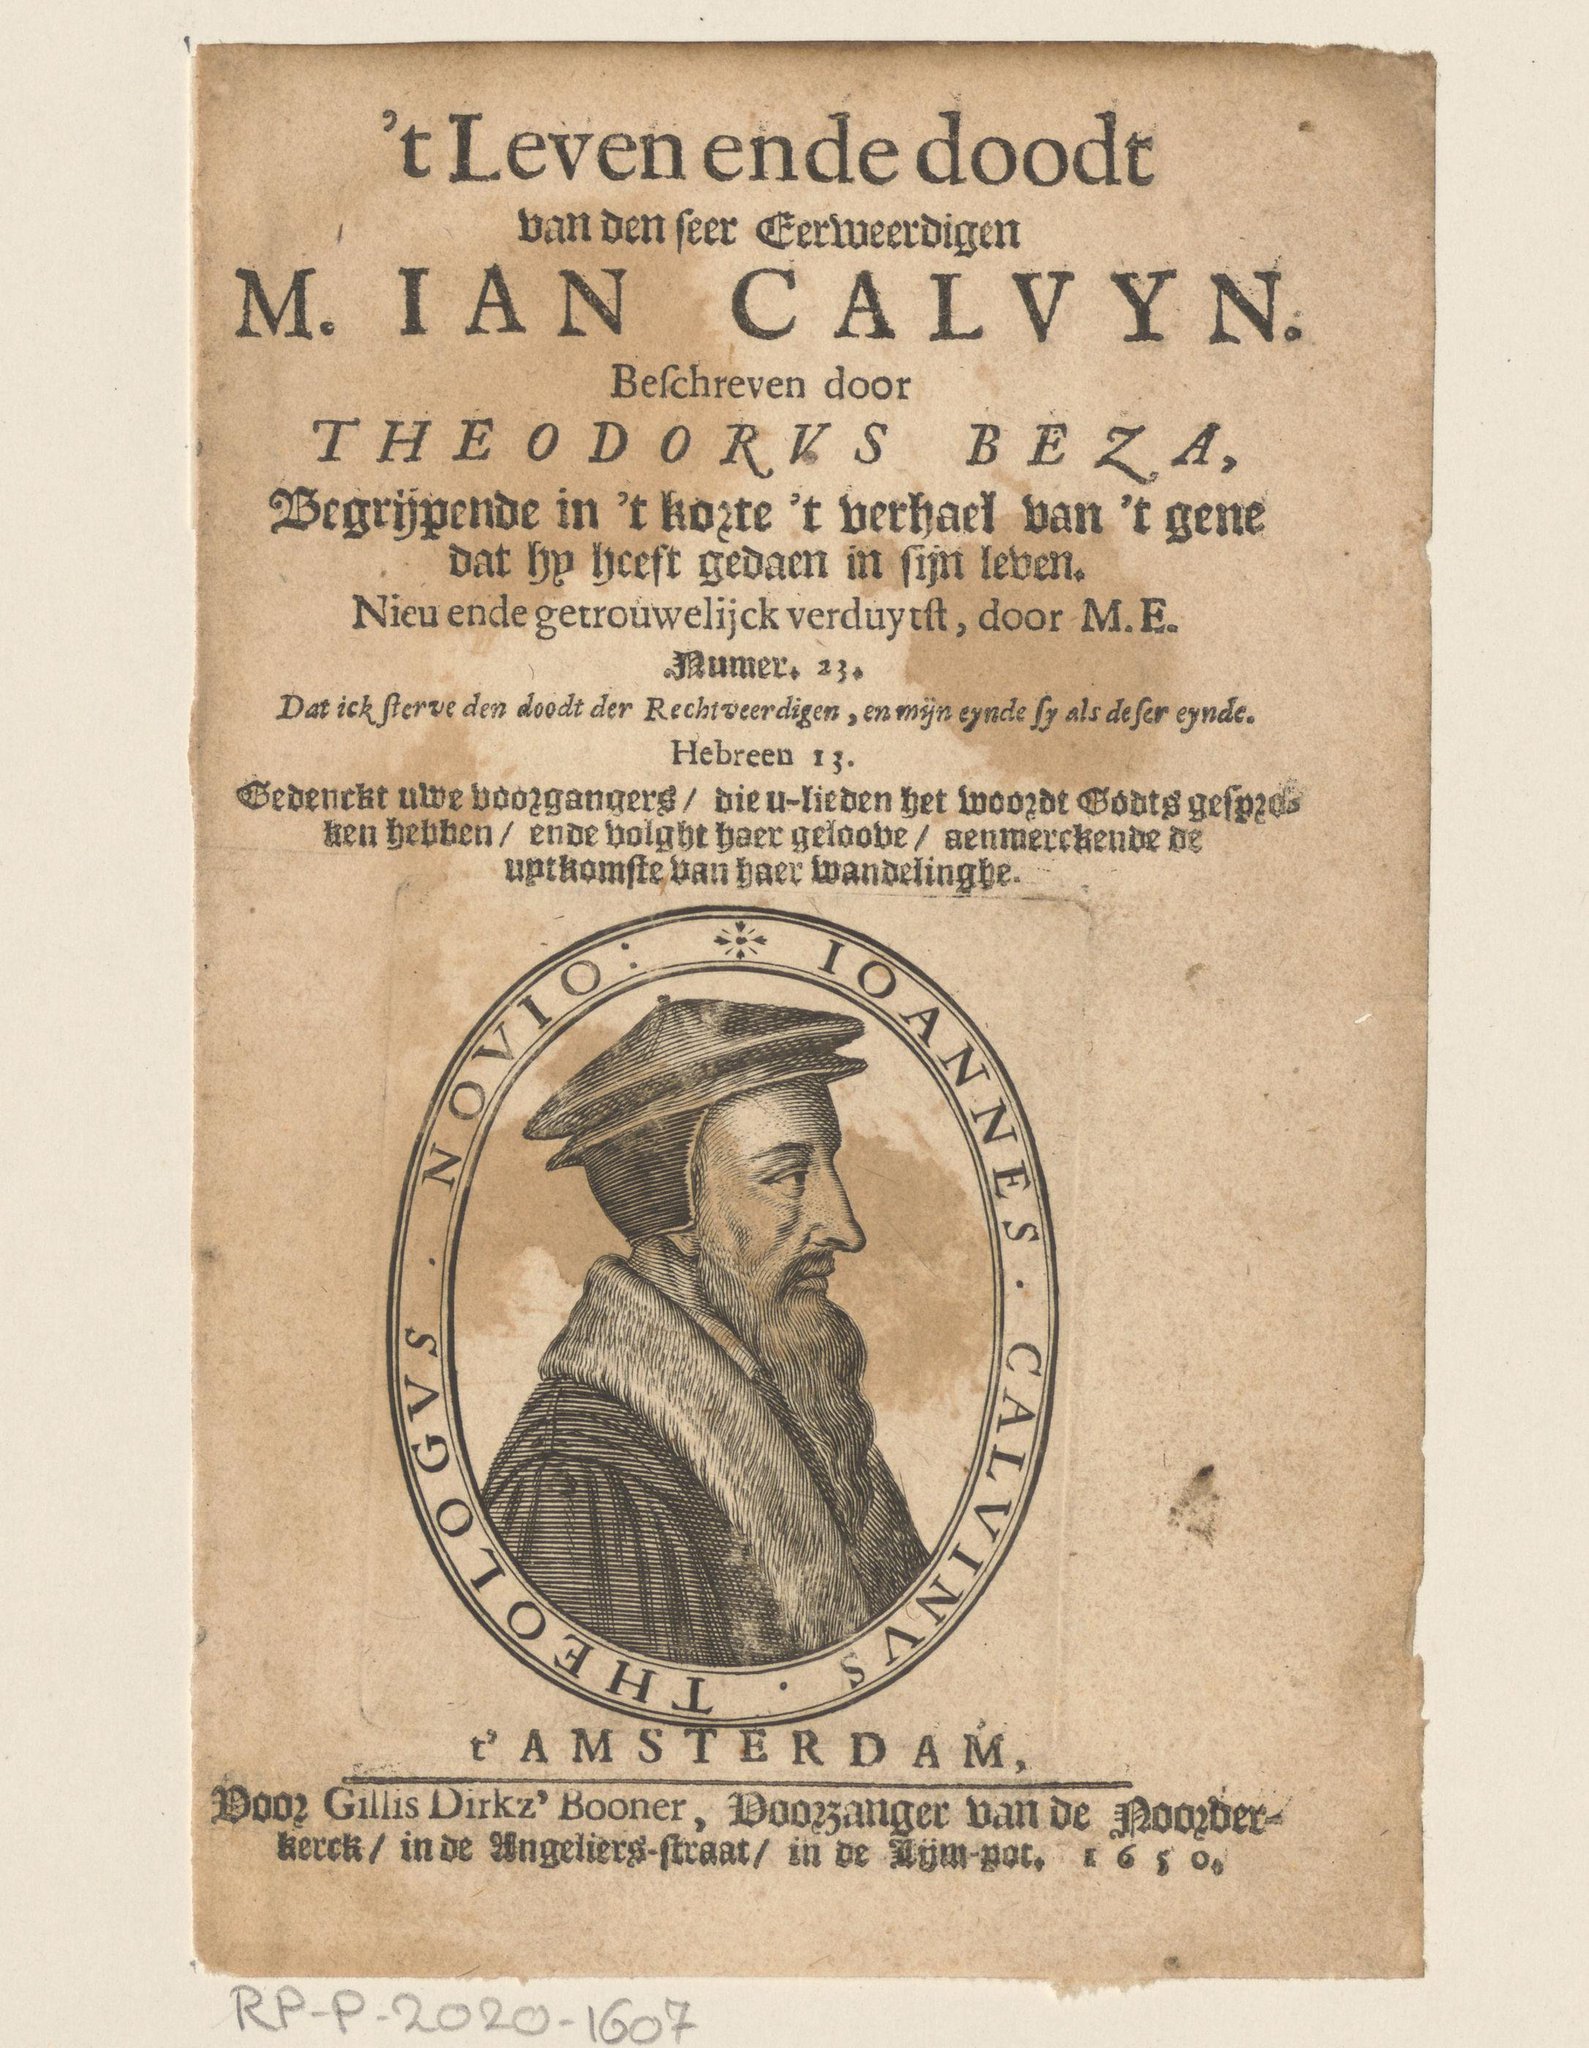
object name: print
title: Titelpagina voor: Theodorus Beza, 't Leven ende doodt van den seer eerweerdigen M. Jan Calvyn, 1650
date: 1650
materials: paper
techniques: engraving, letterpress printing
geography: amsterdam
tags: historical persons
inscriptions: date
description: Titelpagina voor: Beza, Theodorus. 't Leven ende doodt van den seer eerweerdigen M. Jan Calvyn. Amsterdam: Gillis Dirksz Booner, 1650.